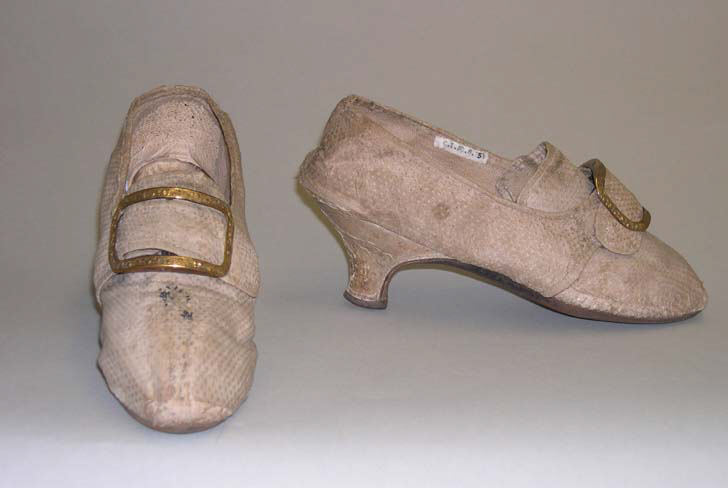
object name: shoe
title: Shoes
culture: british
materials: silk